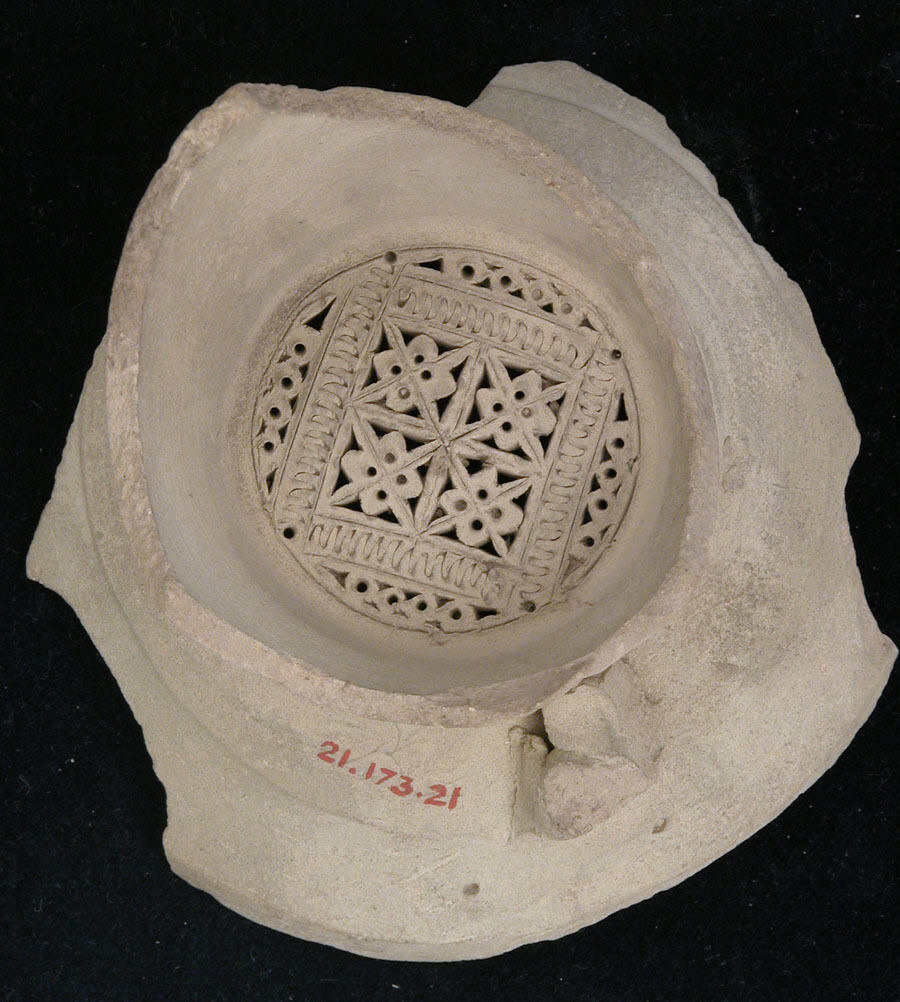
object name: water filter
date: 901-1200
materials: earthenware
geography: egypt